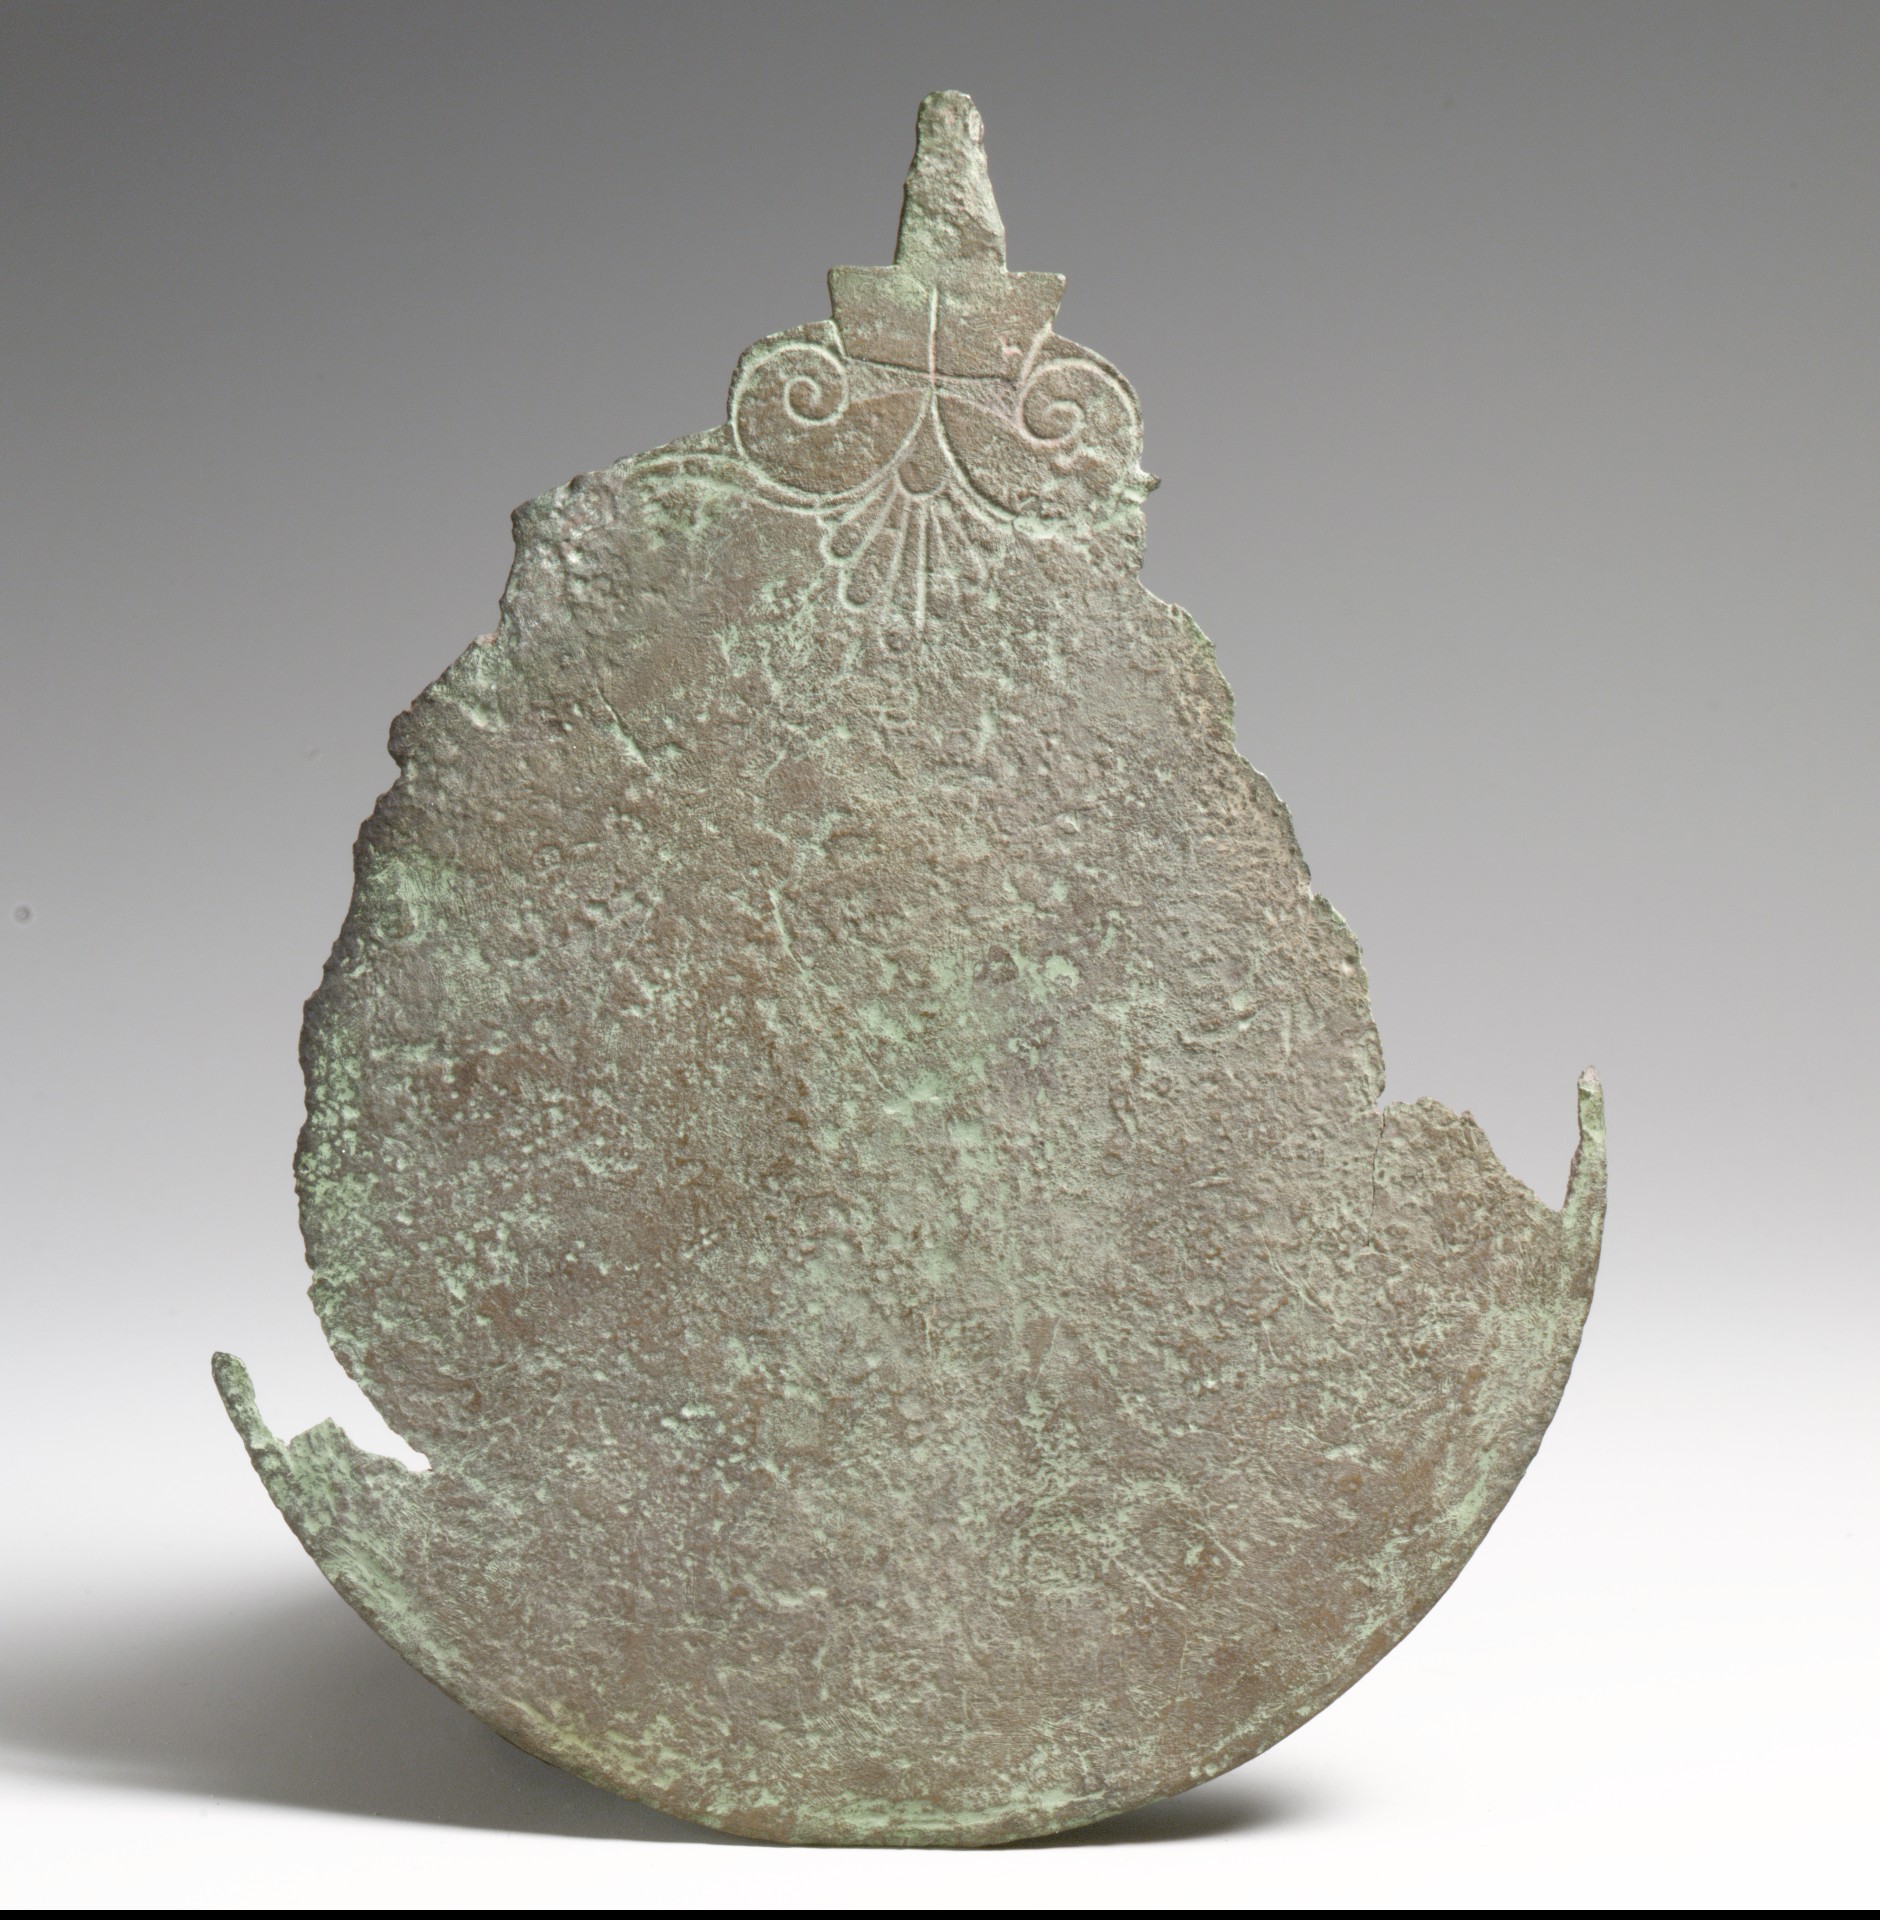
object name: mirror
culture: greek, cypriot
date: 600-501 BCE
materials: bronze